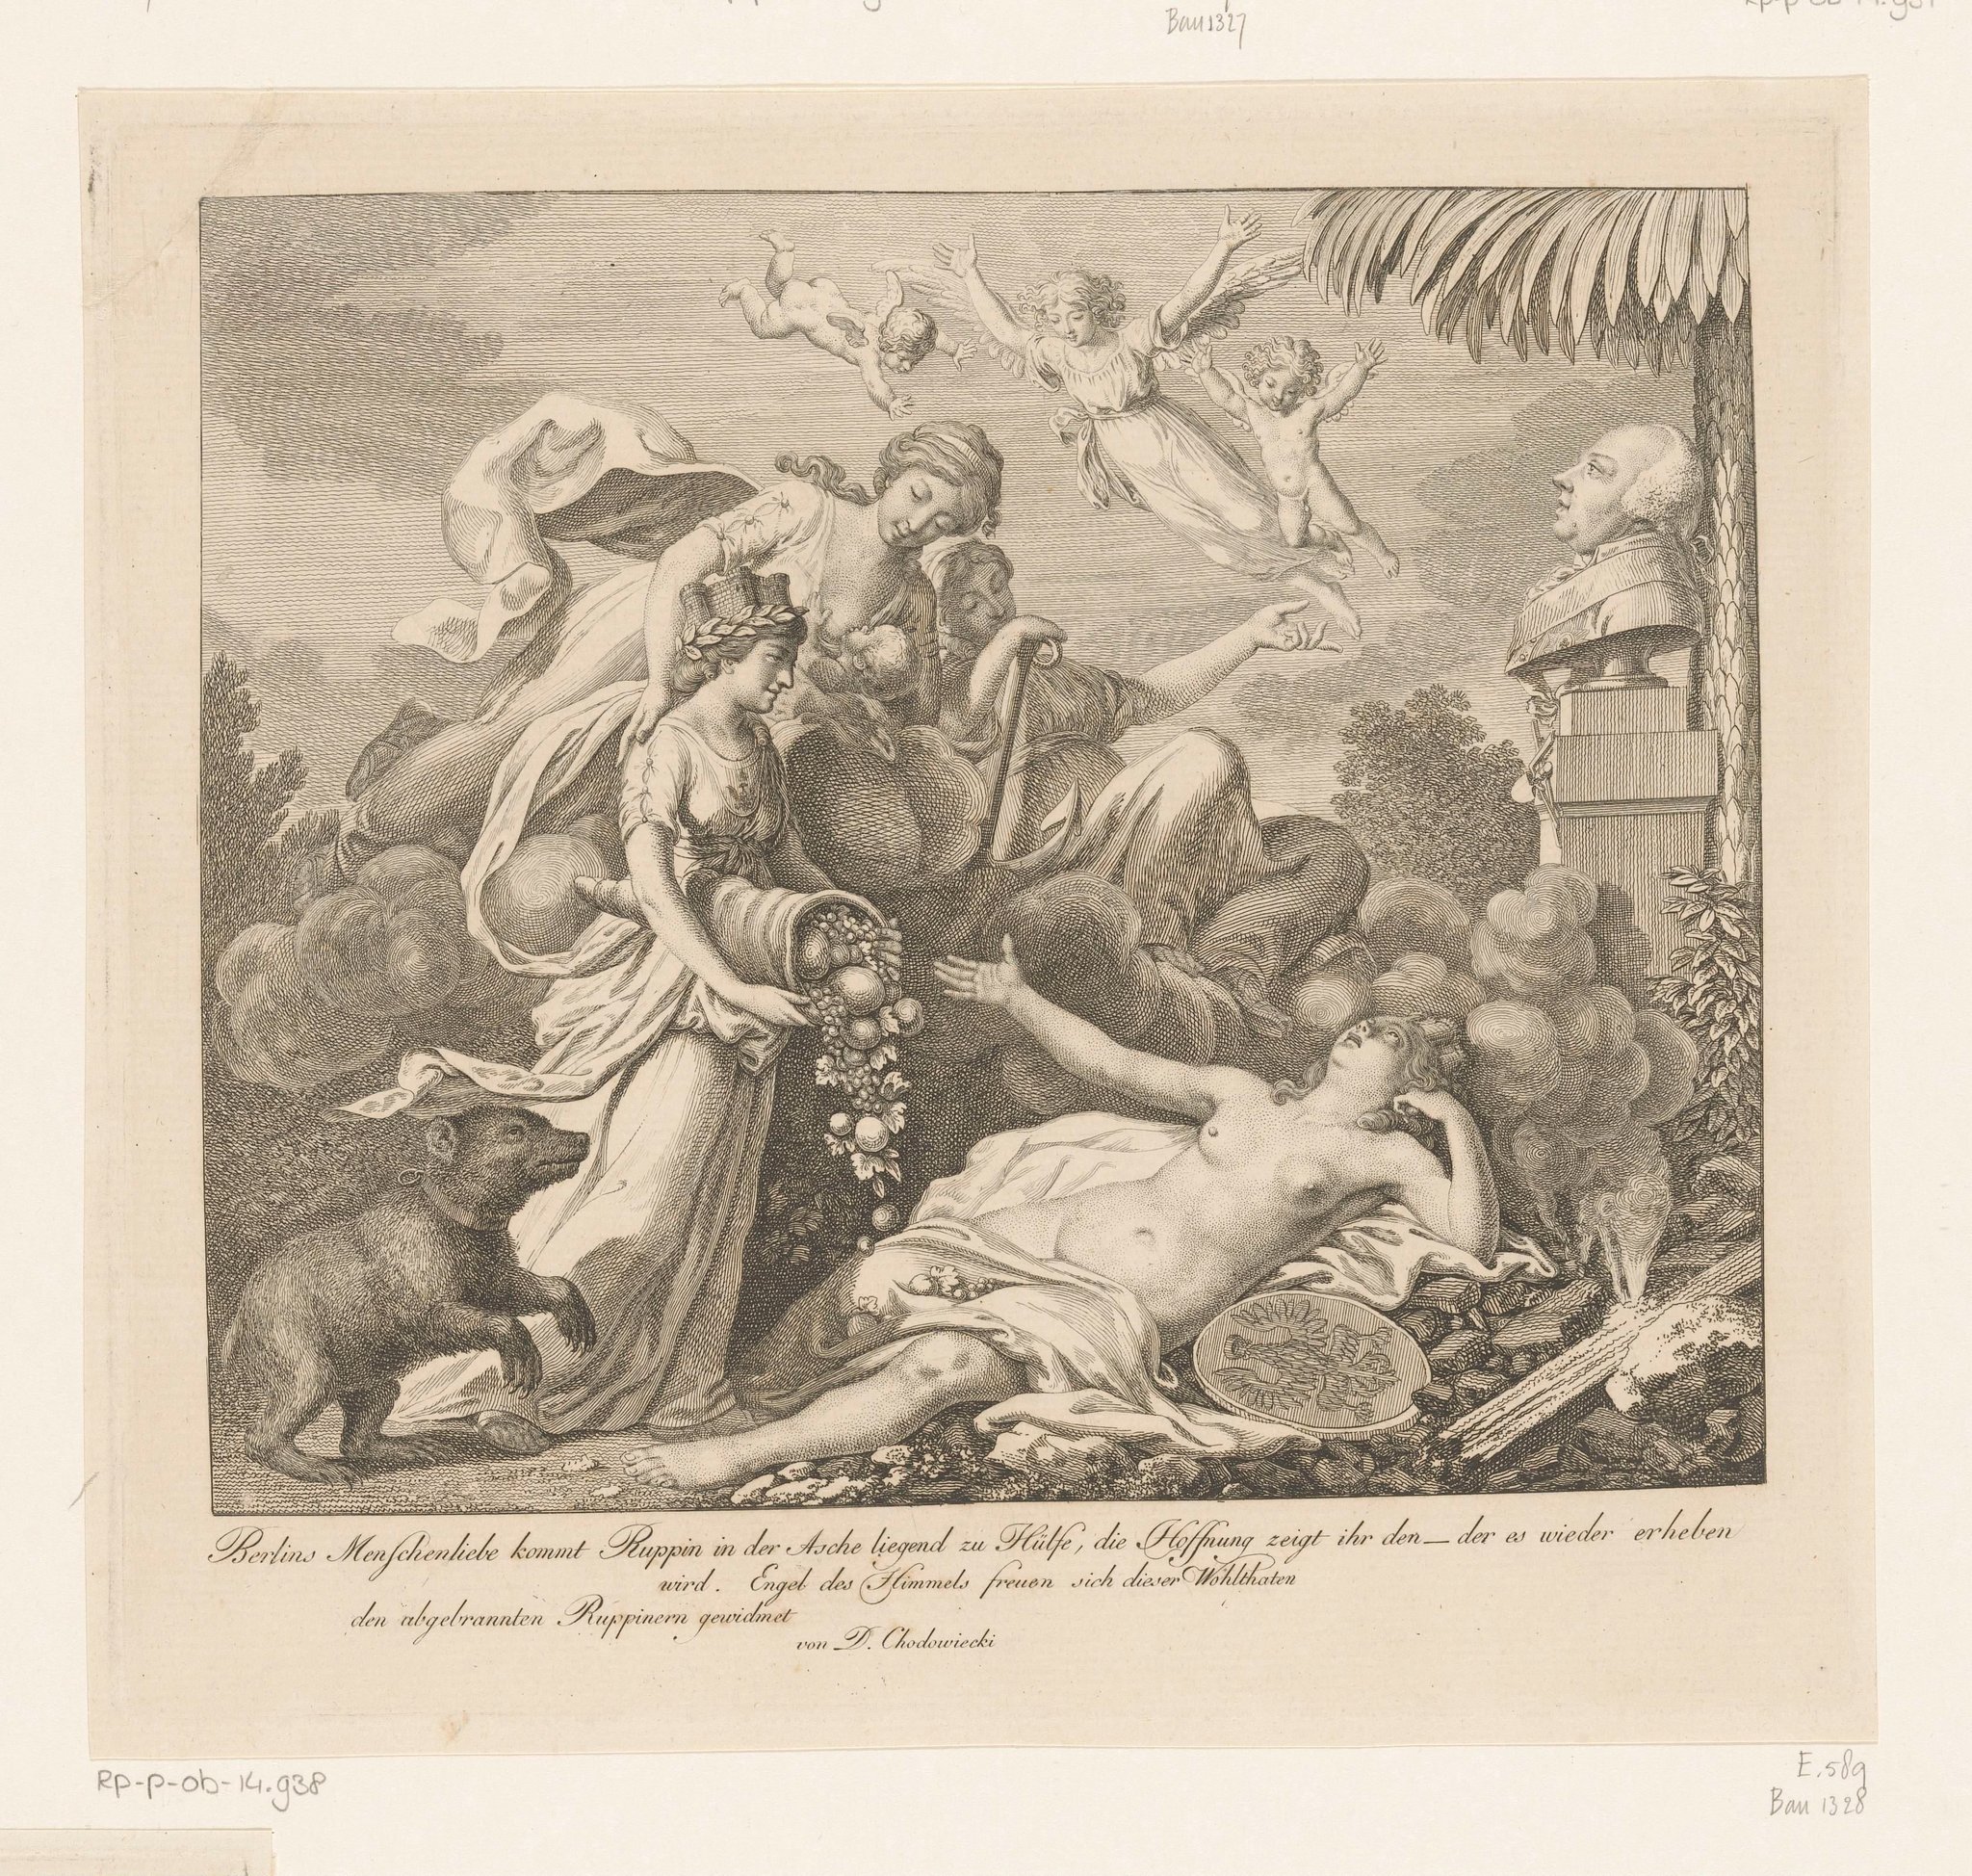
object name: print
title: Allegorie op de stadsbrand van Ruppin in 1787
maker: daniel nikolaus chodowiecki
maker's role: draughtsman, print maker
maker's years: 1726-1801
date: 1787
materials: paper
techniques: etching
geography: berlin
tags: berlin, frederik willem ii (koning van pruisen), city-crown, mural crown, 'cornucopia', horn of plenty, chest, bust, landscapes, personification of a city, town-patron(ess), beasts of prey, predatory animals: bear, love personified, hope; 'speranza', 'speranza delle fatiche' (ripa), trees: palm-tree, angels, armorial bearing, heraldry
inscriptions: collector's mark: Lugt 2228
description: Aan de voet van de buste van Koning Friedrich Wilhelm II ligt een naakte vrouw als personificatie van de Stad Ruppin in de smeulende stadsresten. Links komen de personificaties van Berlijn, liefde en hoop aan om hun hulp aan te bieden.